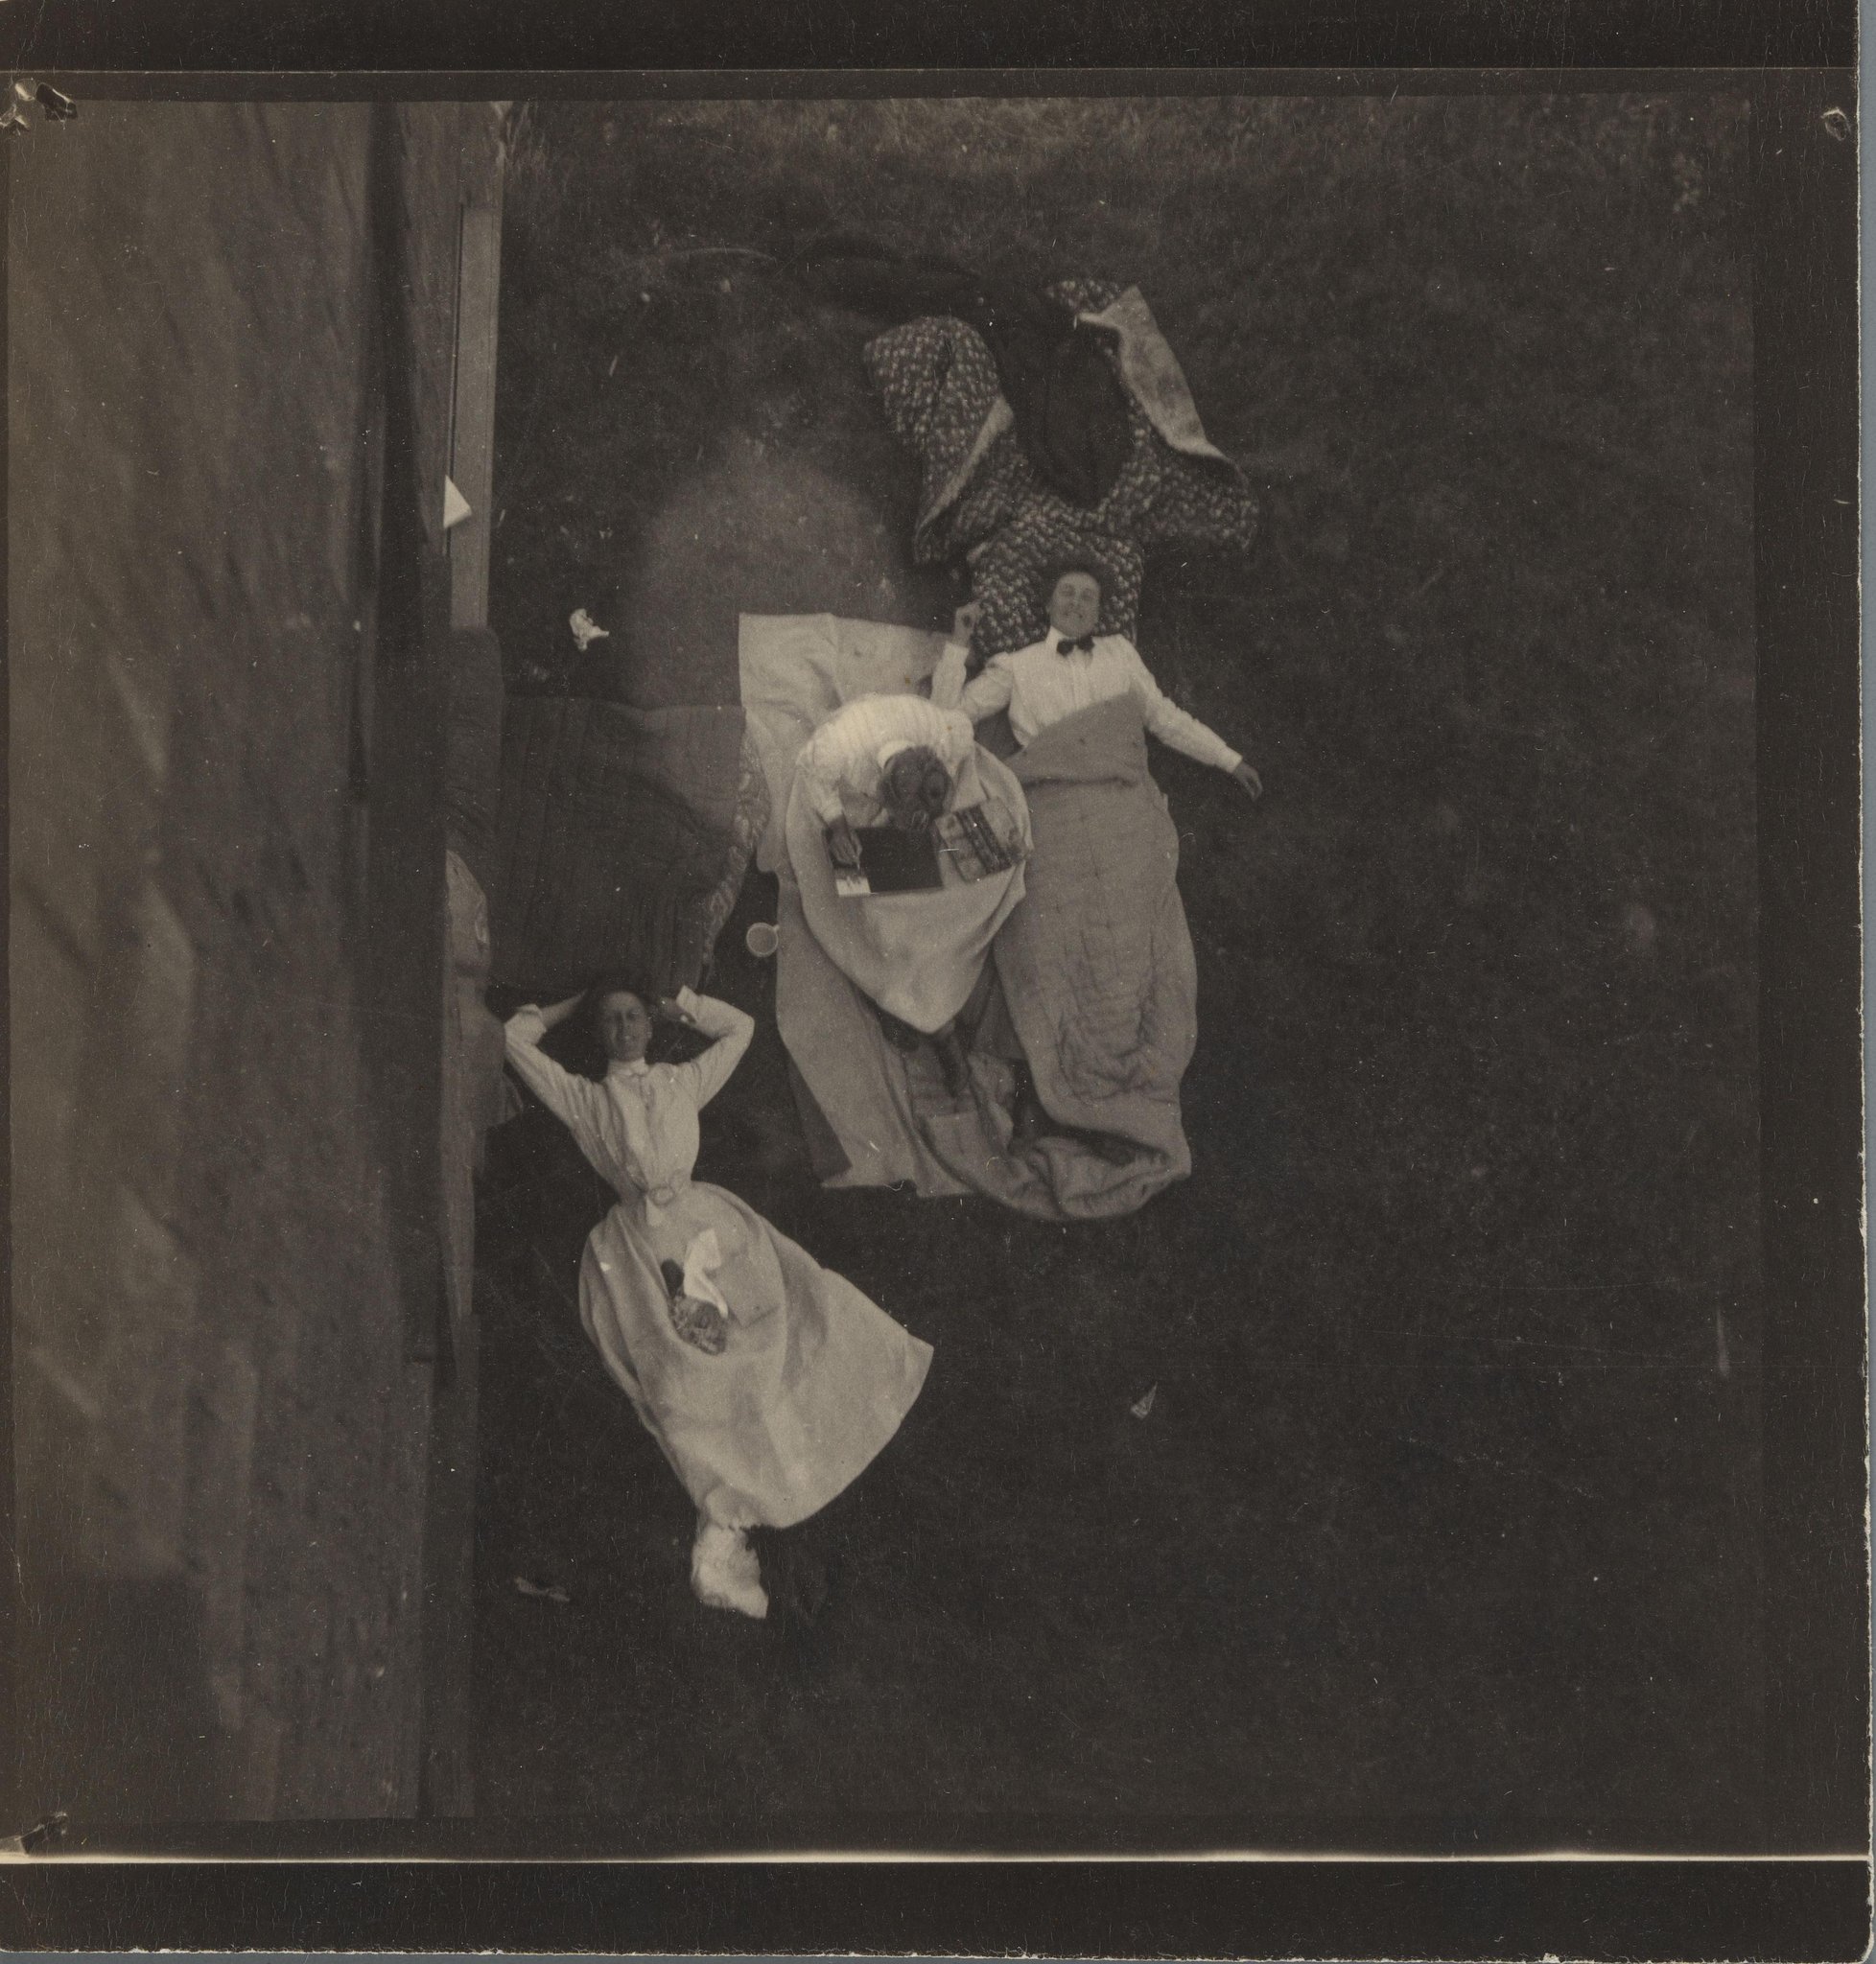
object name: photograph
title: Drie vrouwen van boven gezien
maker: Anonymous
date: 1890-1920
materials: paper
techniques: photography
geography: united states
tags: united states of america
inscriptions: inscription: ‘[onleesbaar]’